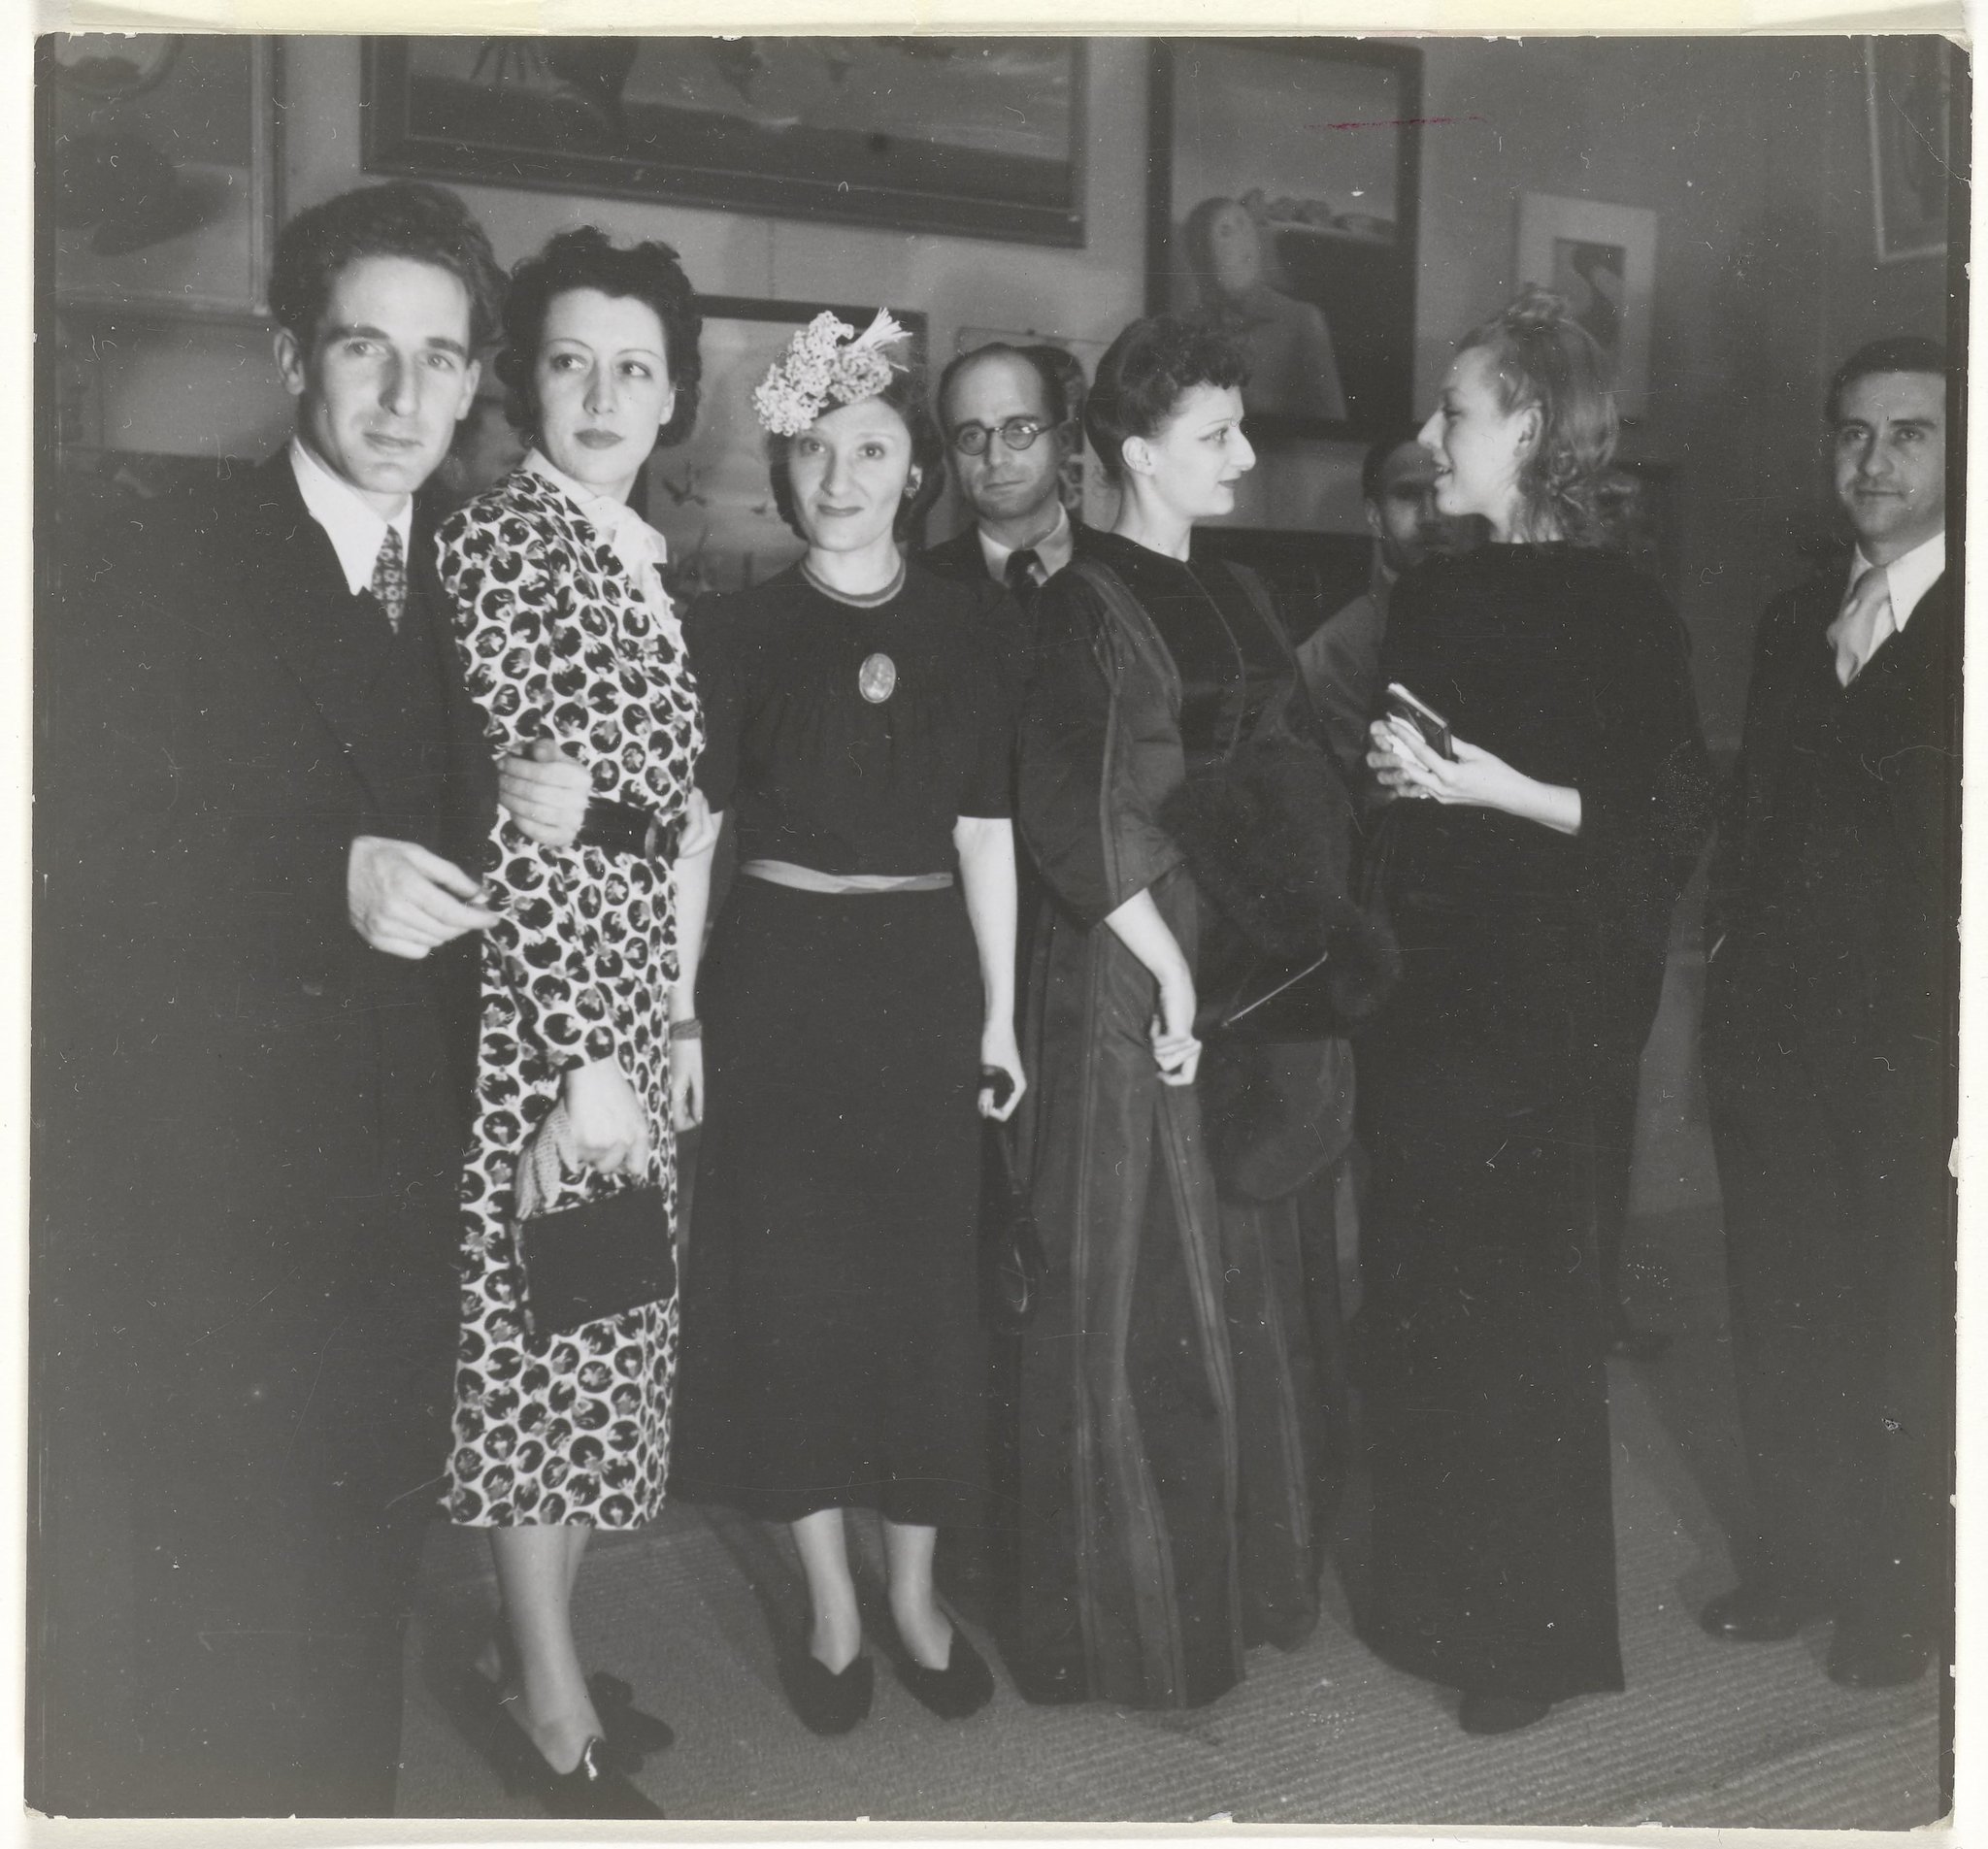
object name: photograph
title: Bezoekers opening surrealisme-tentoonstelling Galerie Robert, Amsterdam 1938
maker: lilly samuel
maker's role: fotograaf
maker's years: 1909-1944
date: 1938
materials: photographic support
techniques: gelatin silver print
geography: amsterdam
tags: print maker, tonny kristians, amsterdam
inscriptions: stamp: ‘galerie robert’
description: Onderdeel van een serie betreffende een reizende tentoonstelling "Exposition Internationale du Surréalisme", in galerie Robert te Amsterdam